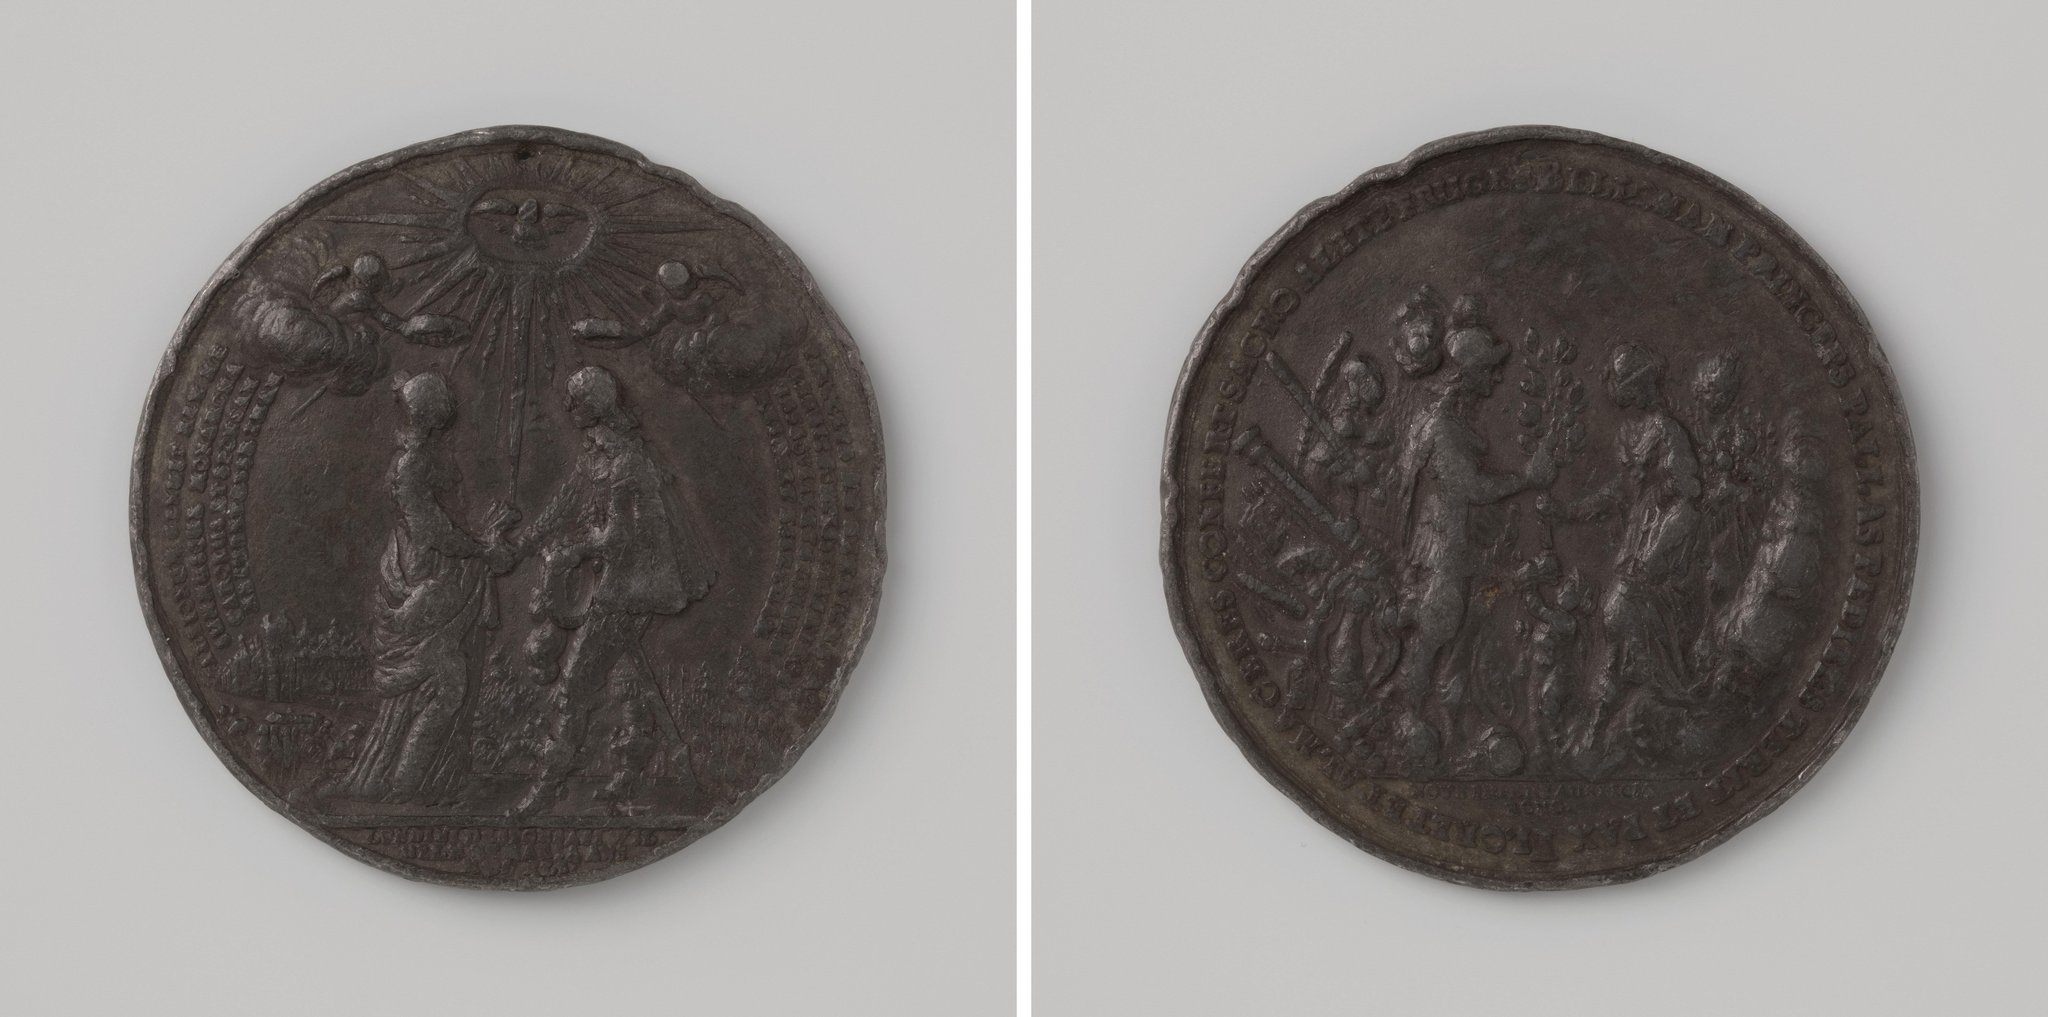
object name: history medal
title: Huwelijk van stadhouder Prins Willem II met Prinses Mary van Engeland te Londen 1641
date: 1641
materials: tin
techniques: casting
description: Gegoten tinnen penning, nogal afgesleten en met een klein draaggat, op de voorzijde het echtpaar, hand in hand, zonbeschenen en door engelen gelauwerd, in een landschap, met meerregelig omschrift en afsnedetekst, op de keerzijde Willem als Pallas die Mars vertreedt en van de Vrede een olijftak ontvangt, met omschrift en afsnedetekst.